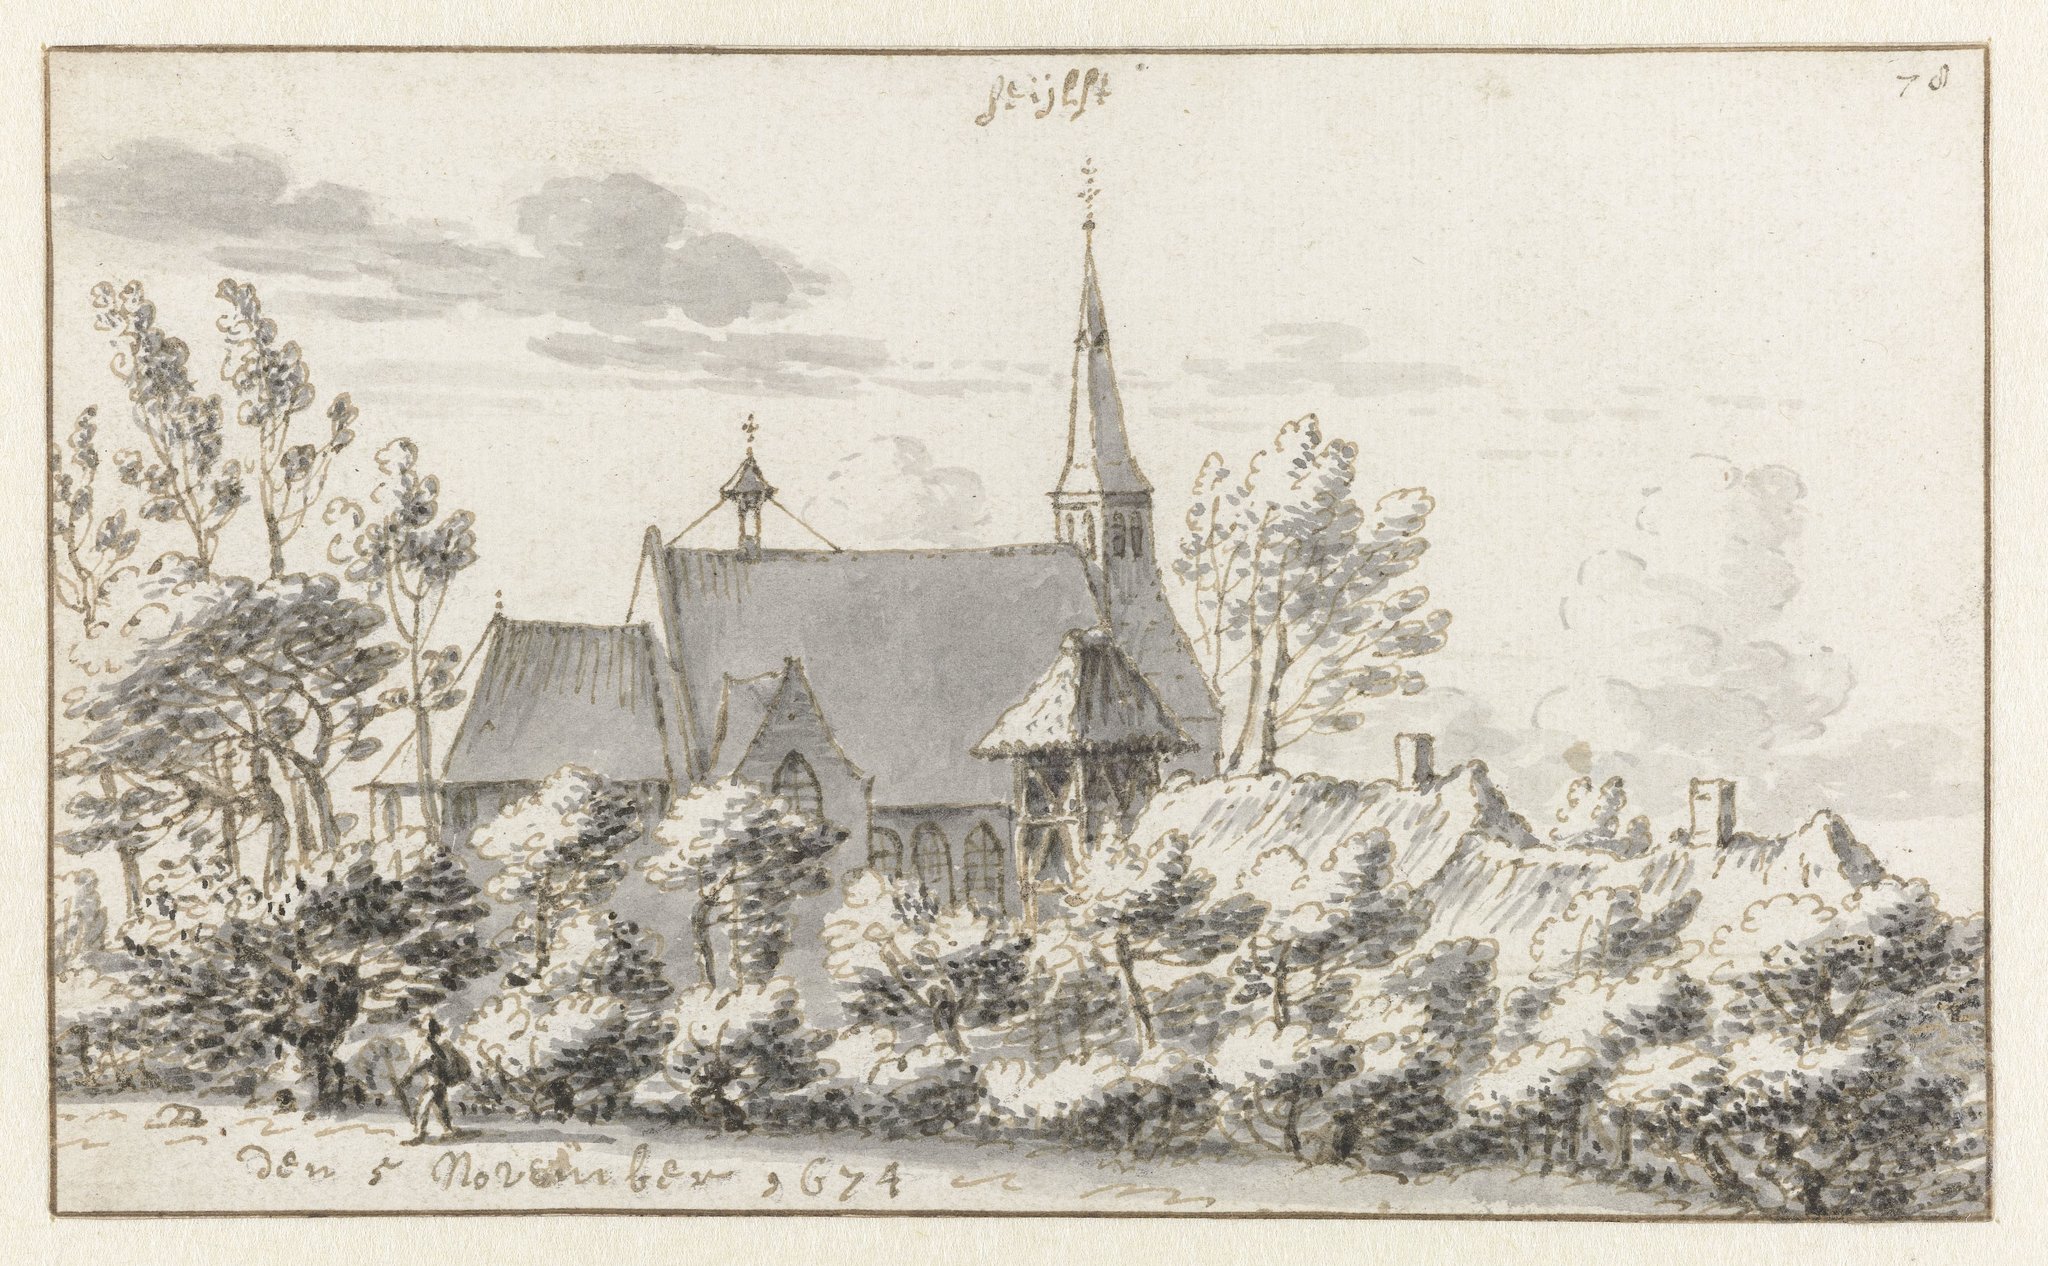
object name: drawing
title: View of Zeelst, Noord-Brabant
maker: barend klotz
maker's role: draughtsman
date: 1674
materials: ink, paper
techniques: brush, pen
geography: zeelst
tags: prospect of village, silhouette of village, church (exterior), zeelst